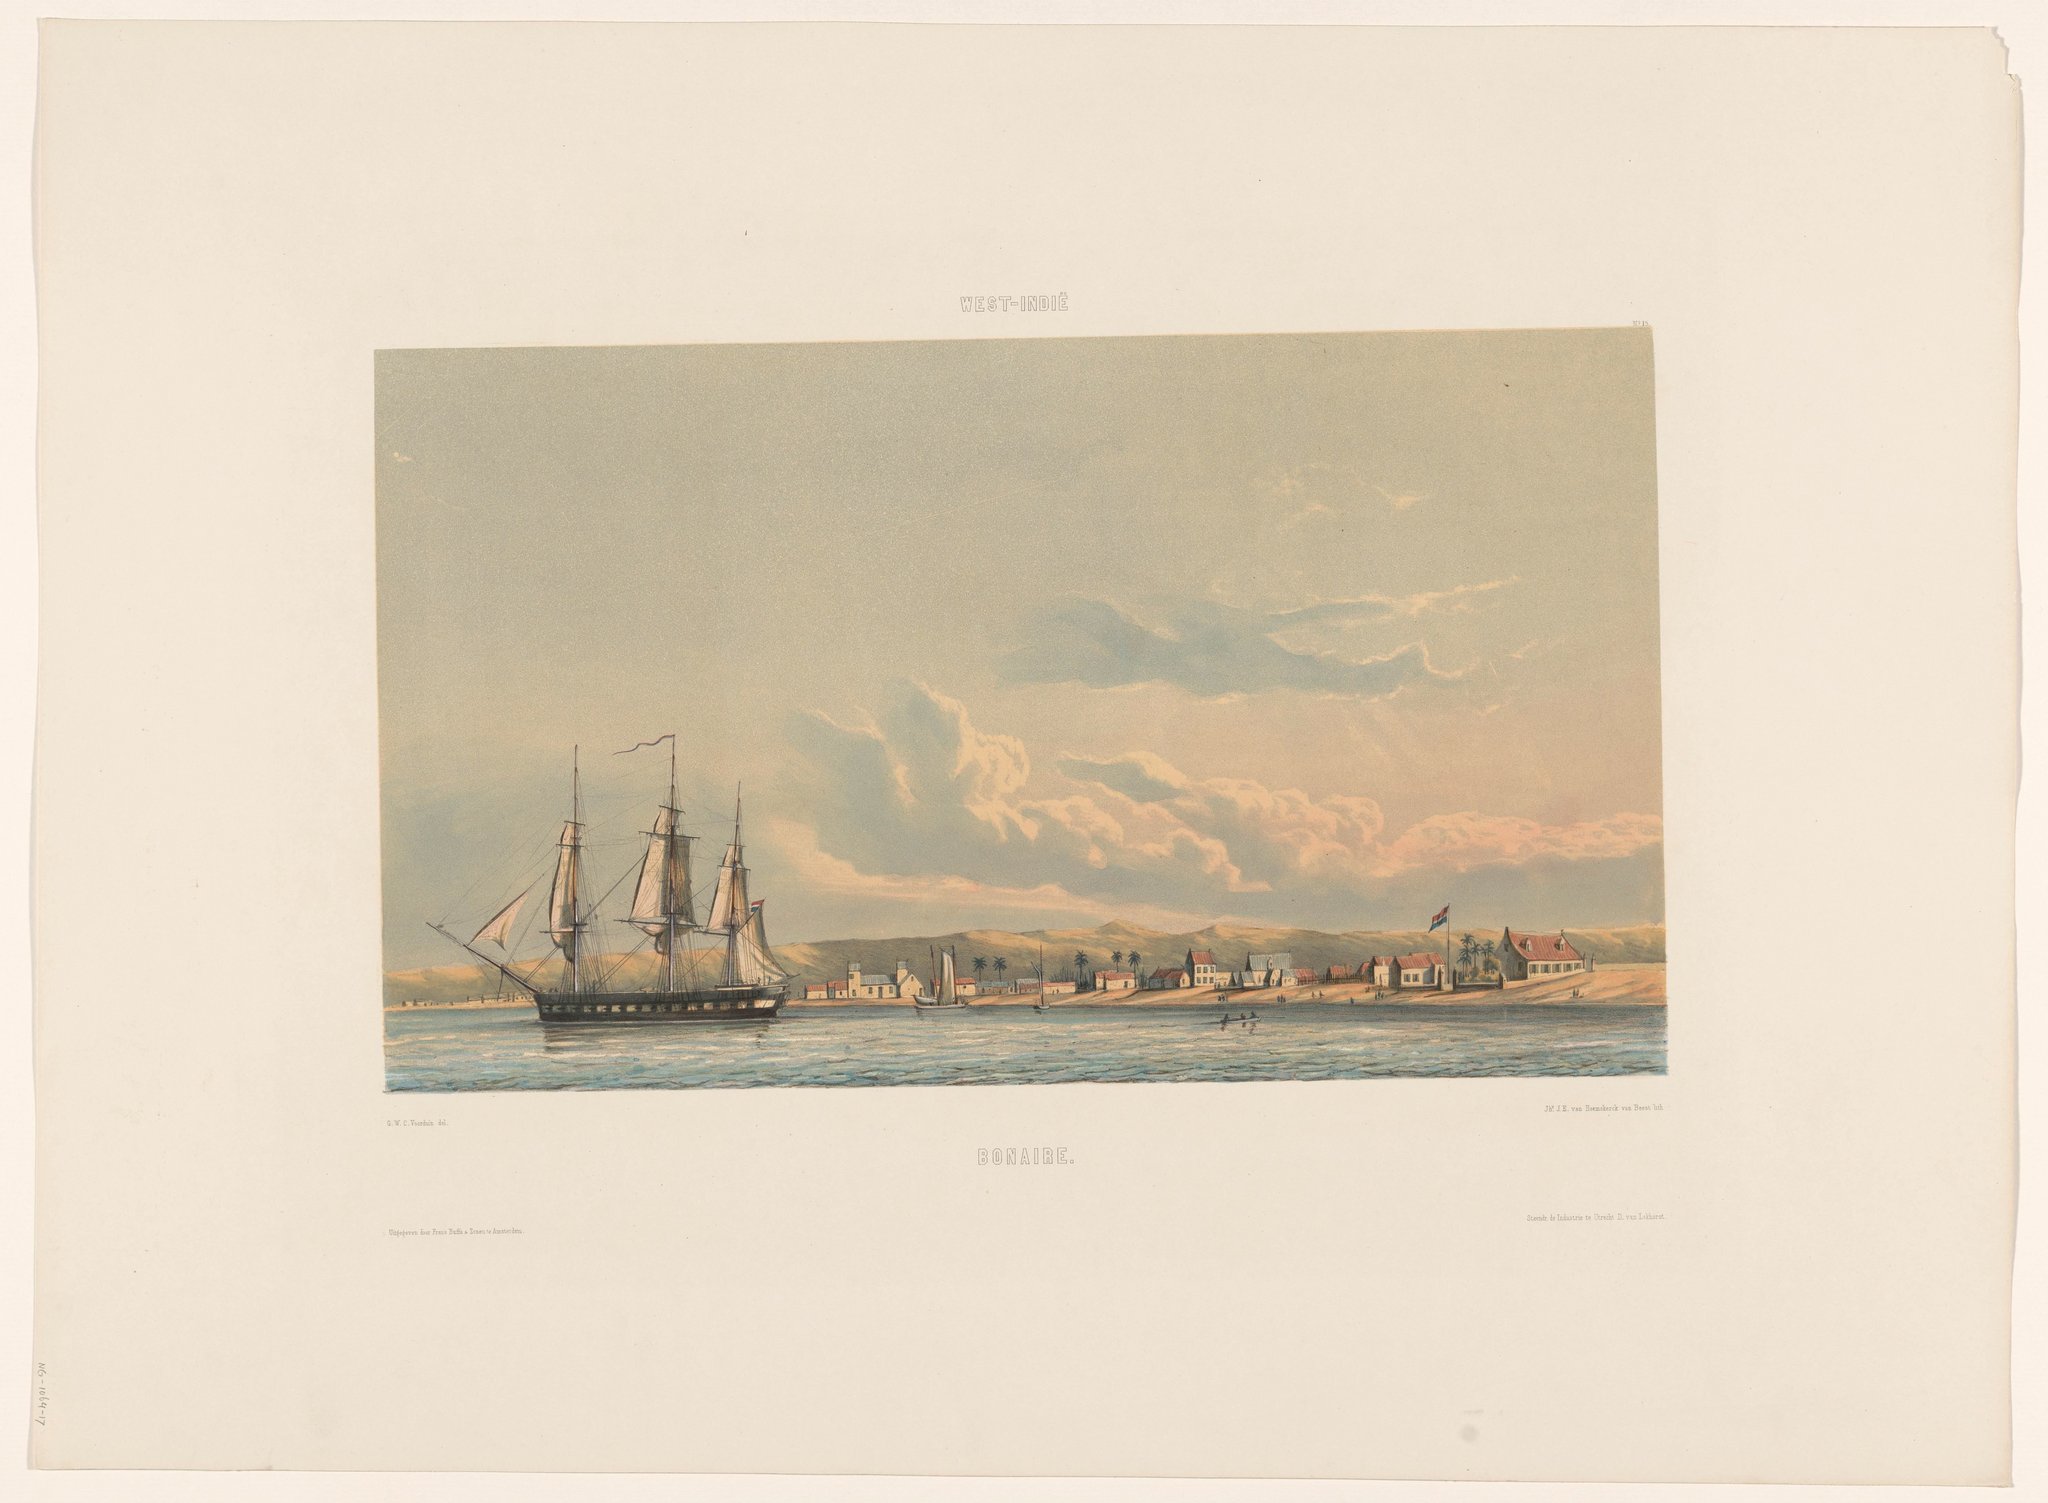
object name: print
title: Bonaire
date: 1860-1862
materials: paper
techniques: lithograph, hand coloring, lacquer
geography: netherlands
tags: colonial system, sailing-ship, sailing-boat, prospect of city, town panorama, silhouette of city (+ city(-scape) with figures, staffage)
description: Een Nederlandse driemaster voor de kust van Bonaire. Onderdeel van het plaatwerk 'Gezigten uit Neerland's West-Indien'.